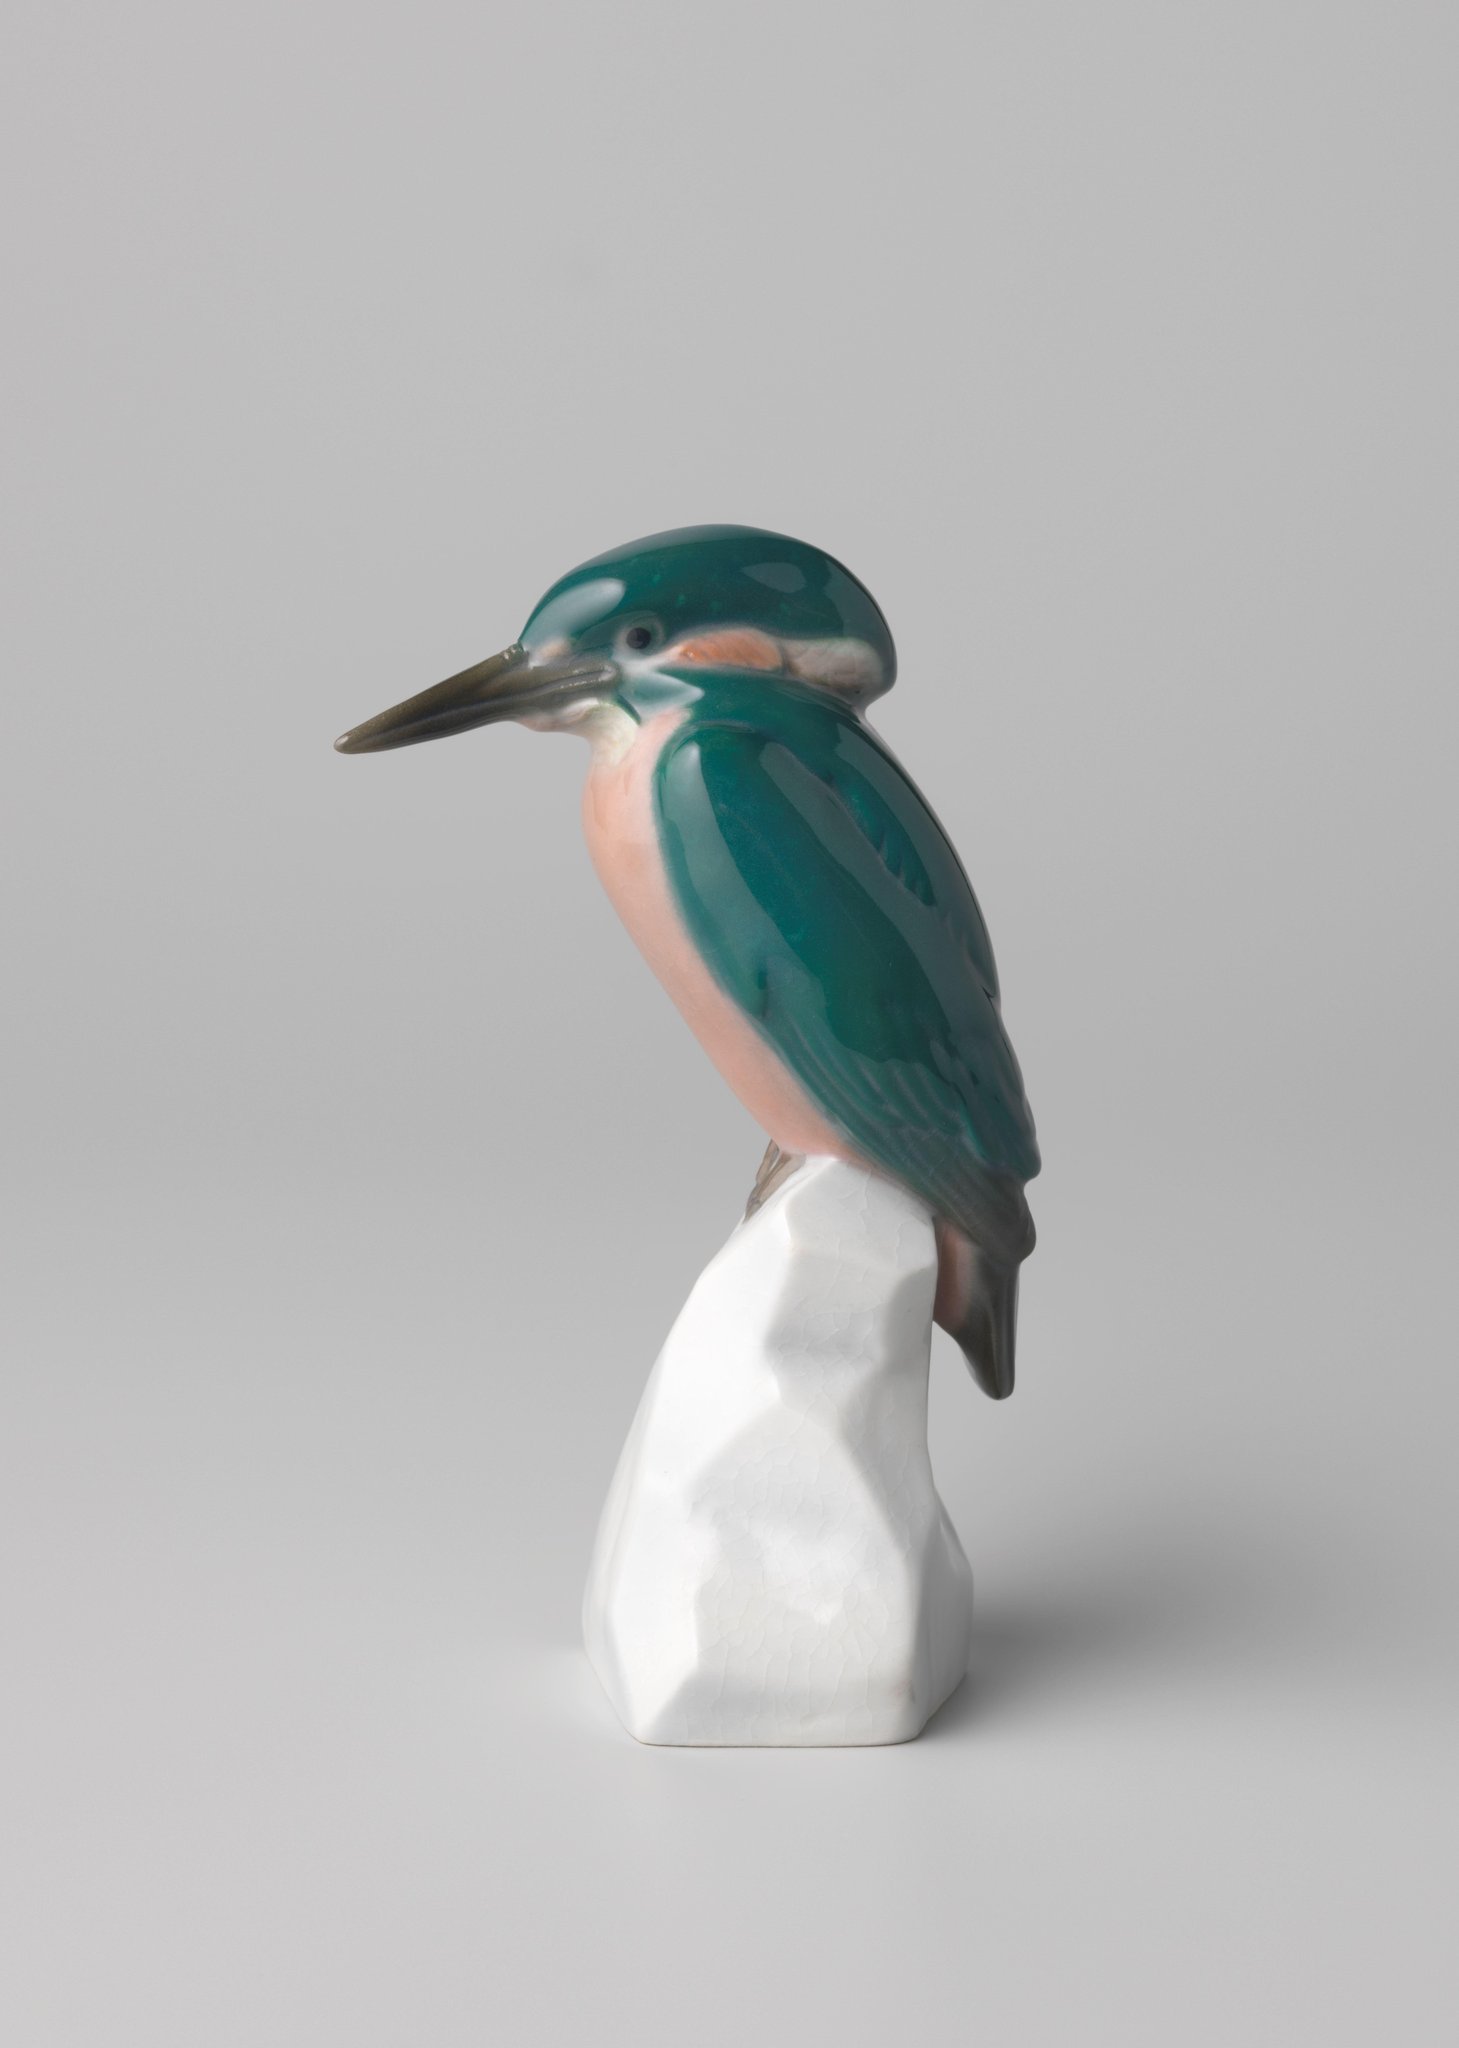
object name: figure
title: Figuur in de vorm van een ijsvogel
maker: paul zeiller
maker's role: sculptor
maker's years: 1880-1915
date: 1910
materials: porcelain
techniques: painted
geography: lichte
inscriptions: signature: ‘Paul Zeiller’, mark: ‘fabrieksmerk Kunst HEUBACH Porzellan in groen, modelnummer 6845 (?).’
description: Figuur van porselein in de vorm van een ijsvogel in blauw-groen en roze op een witte rots. Gemerkt: HEUBACH Porzellan; onduidelijk modelnummer. Achter op de rots gesigneerd: Paul Zeiller. Gemerkt met: fabrieksmerk Kunst HEUBACH Porzellan in groen, modelnummer 6845 (?).